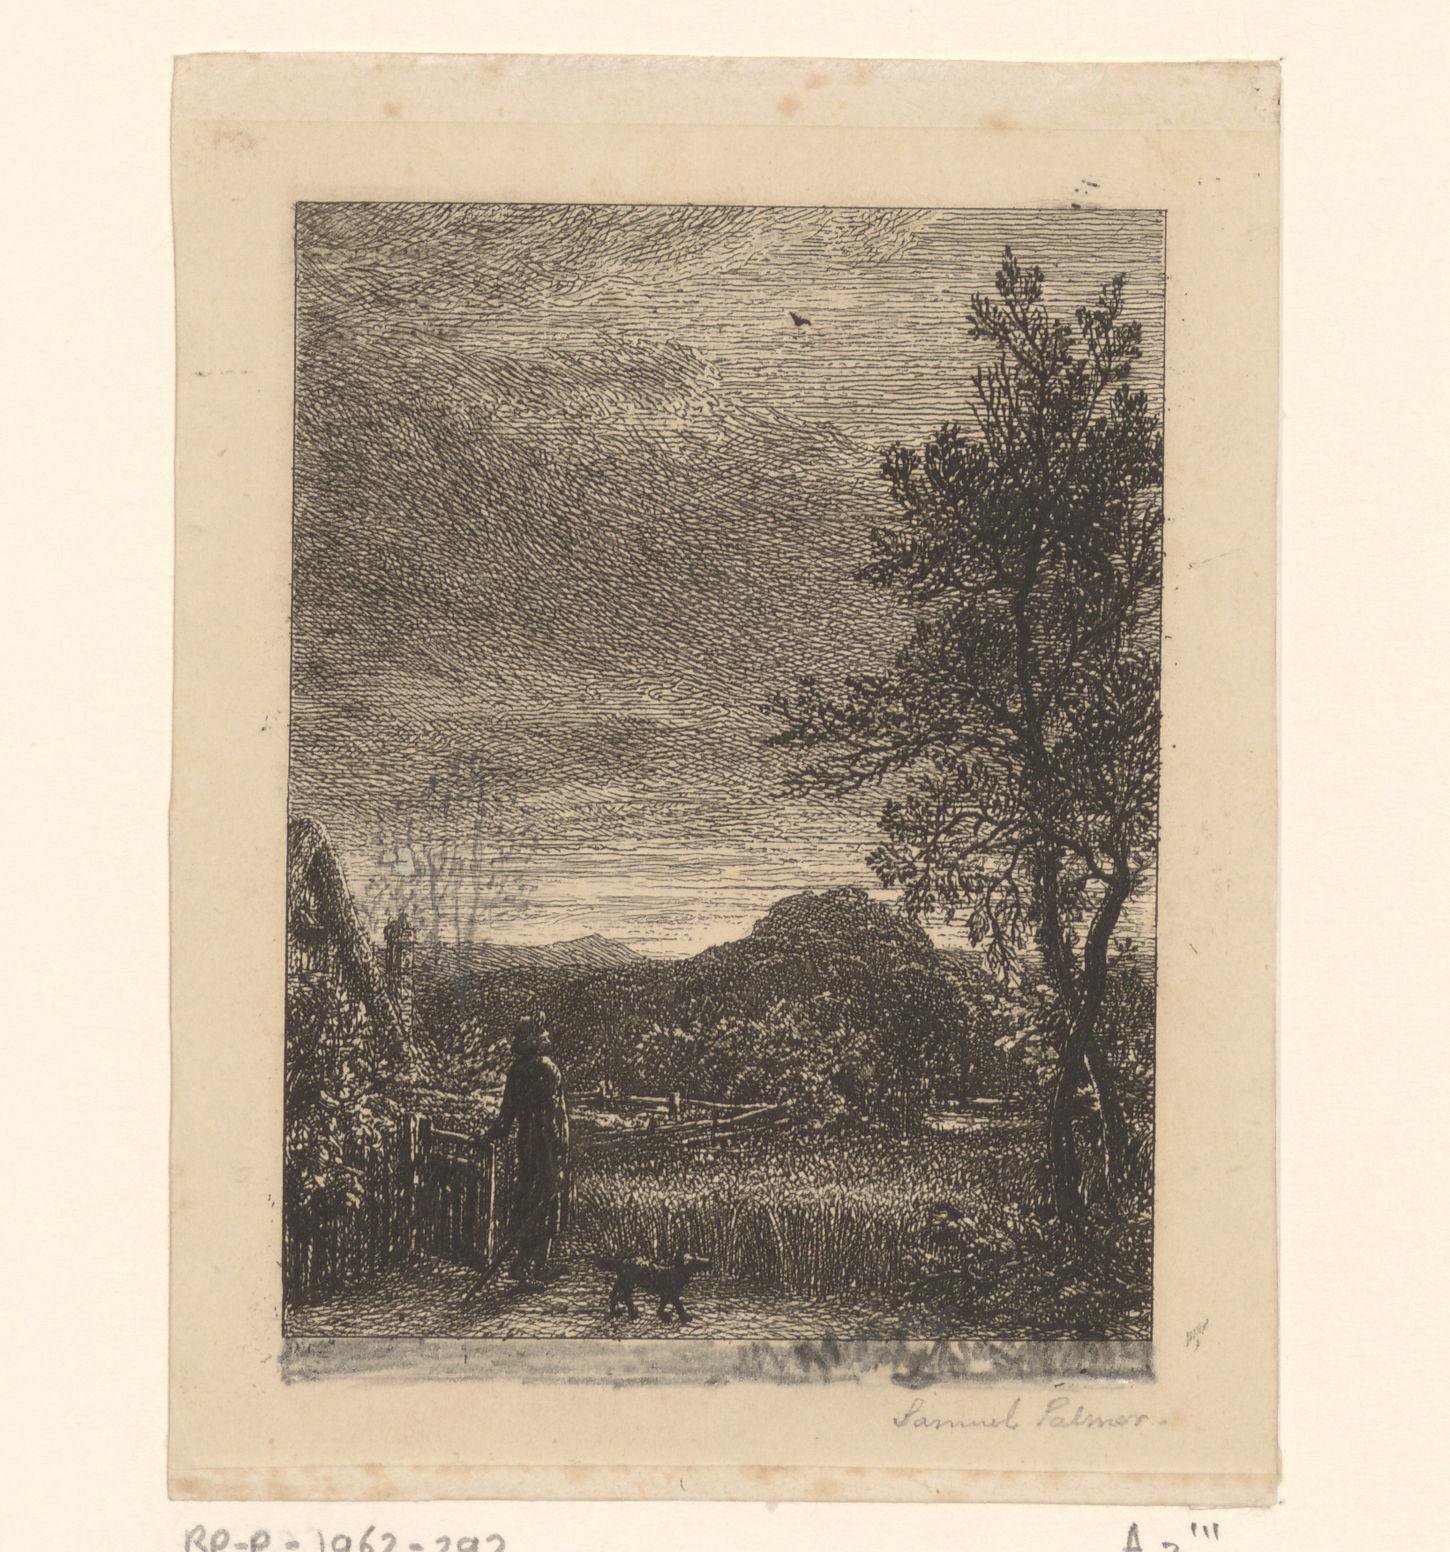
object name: print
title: Man en hond kijken naar een leeuwerik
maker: samuel palmer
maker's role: draughtsman, painter, print maker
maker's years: 1805-1881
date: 1850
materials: paper, pencil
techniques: etching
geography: england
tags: cottage, song-birds: lark, dog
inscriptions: collector's mark: Lugt 2228, signature: ‘Samuel Palmer’, collector's mark: Lugt 1342, collector's mark: Lugt 2760